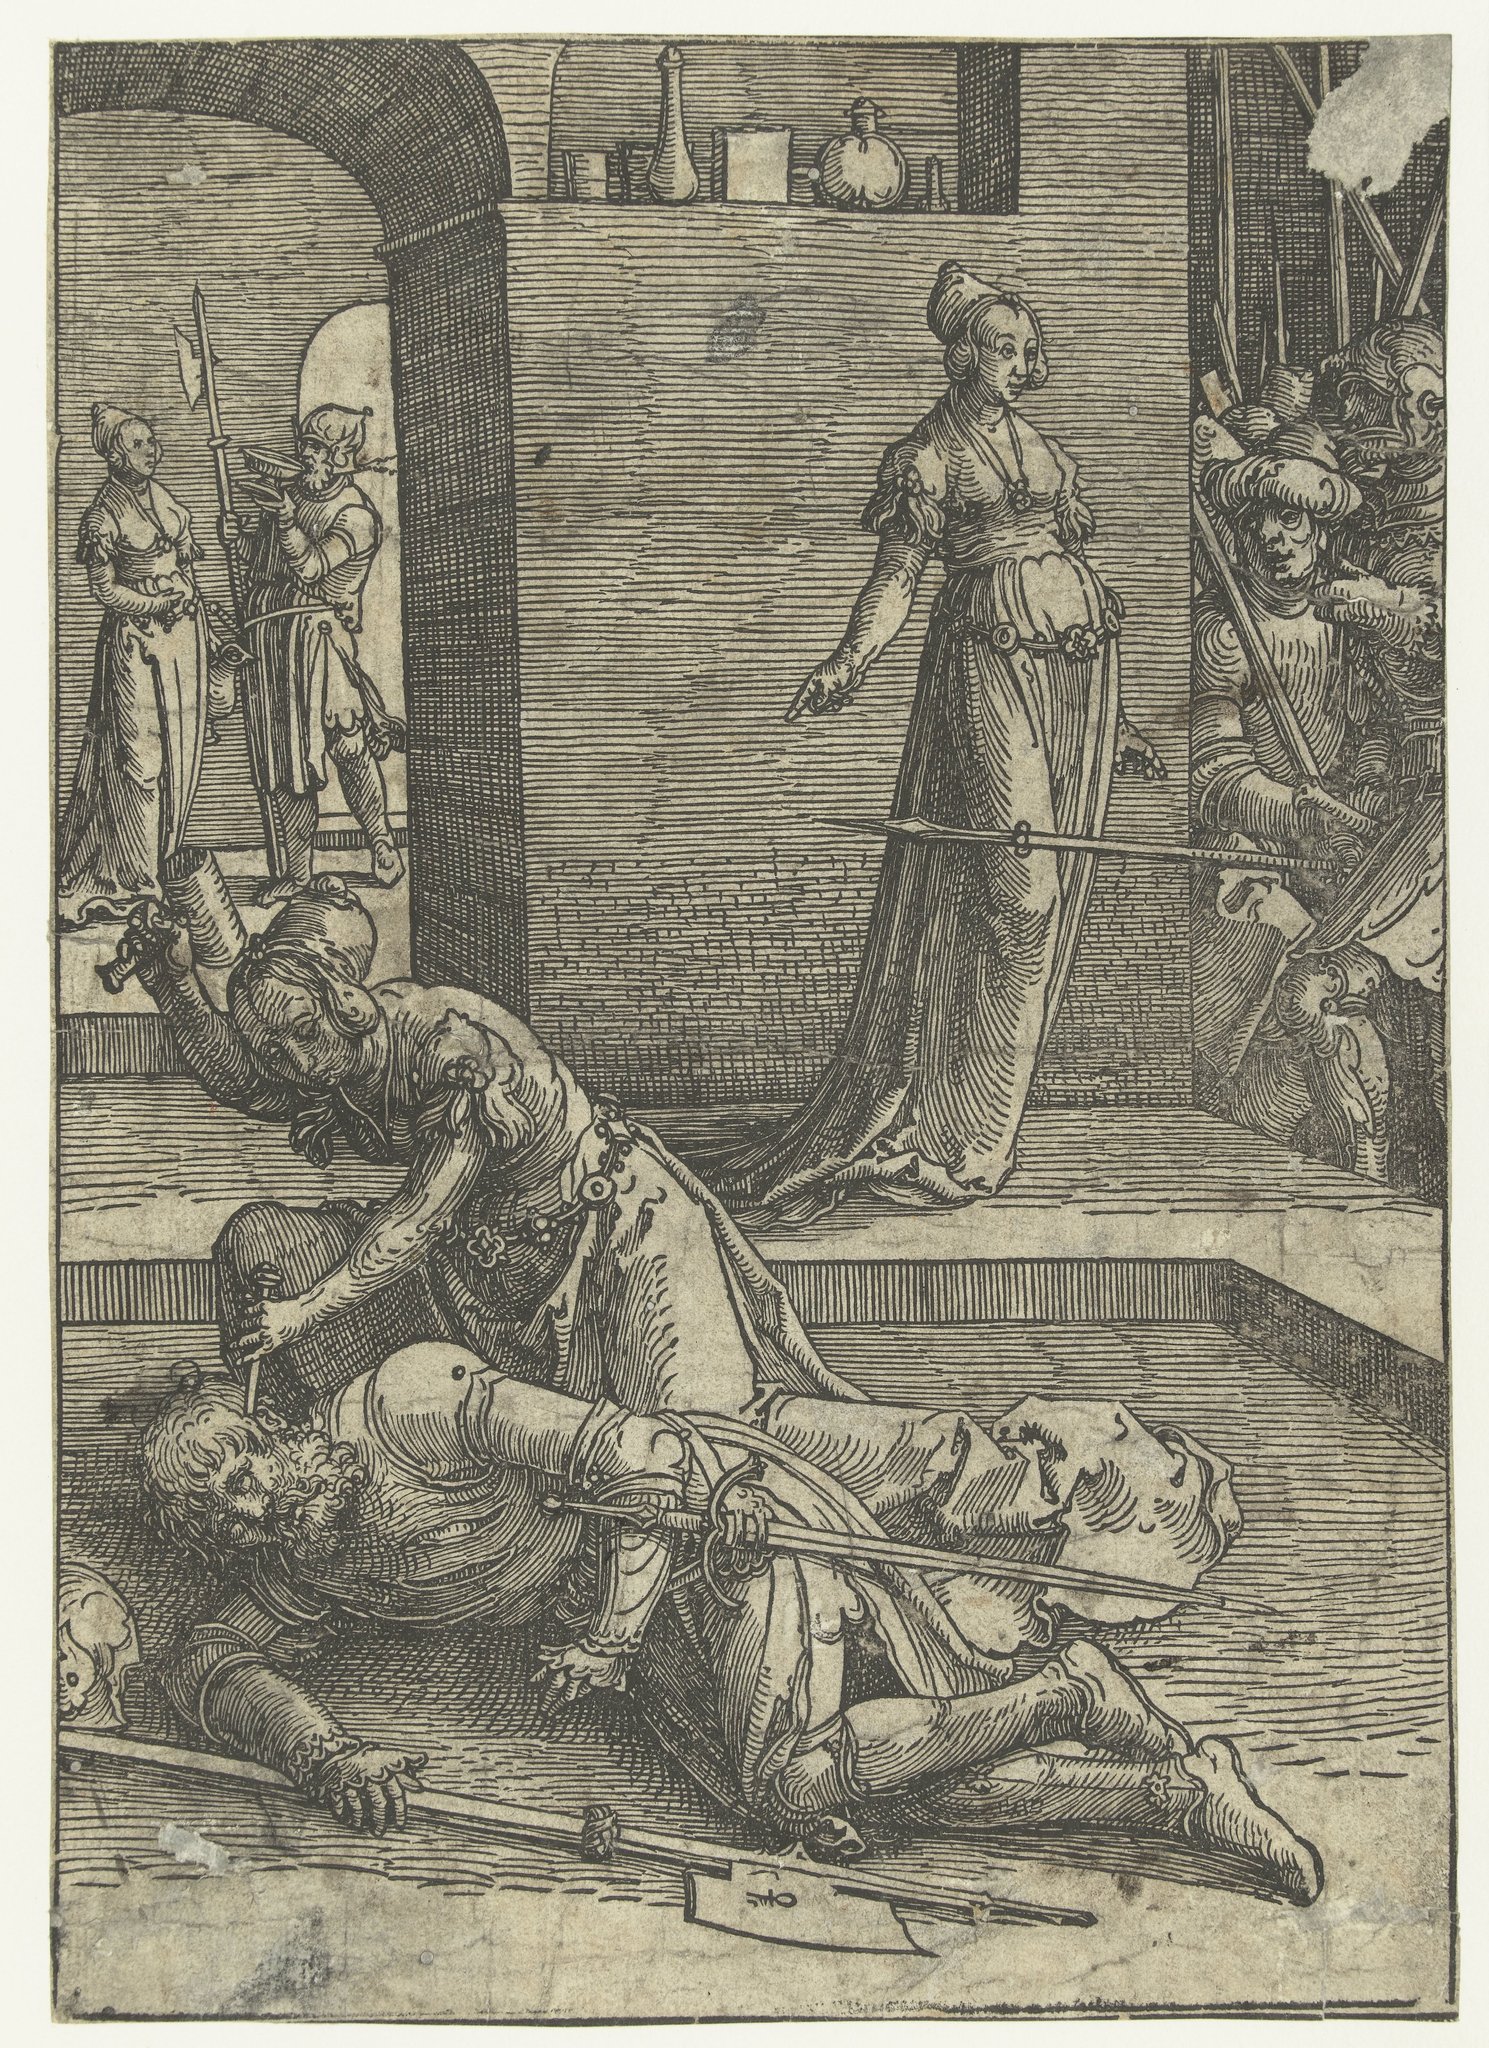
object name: print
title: Jaël doodt Sisera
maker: lucas van leyden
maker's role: draughtsman, painter, print maker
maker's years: 1494-1533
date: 1515-1519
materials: paper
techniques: woodcut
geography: low countries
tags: jael kills the sleeping sisera by hitting the nail through his temples, barak comes to jael's tent; she shows him sisera's body, sisera asks for water and is given milk by jael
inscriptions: collector's mark: Lugt 240, collector's mark: Lugt 2228a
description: Drie scènes uit het verhaal van Jaël. Links: Jaël geeft Sisera te drinken. Midden: Jaël doodt slapende Sisera door tentpin door zijn hoofd te slaan. Rechts: Jaël toont Berak en zijn mannen waar zij Sisera kunnen vinden.